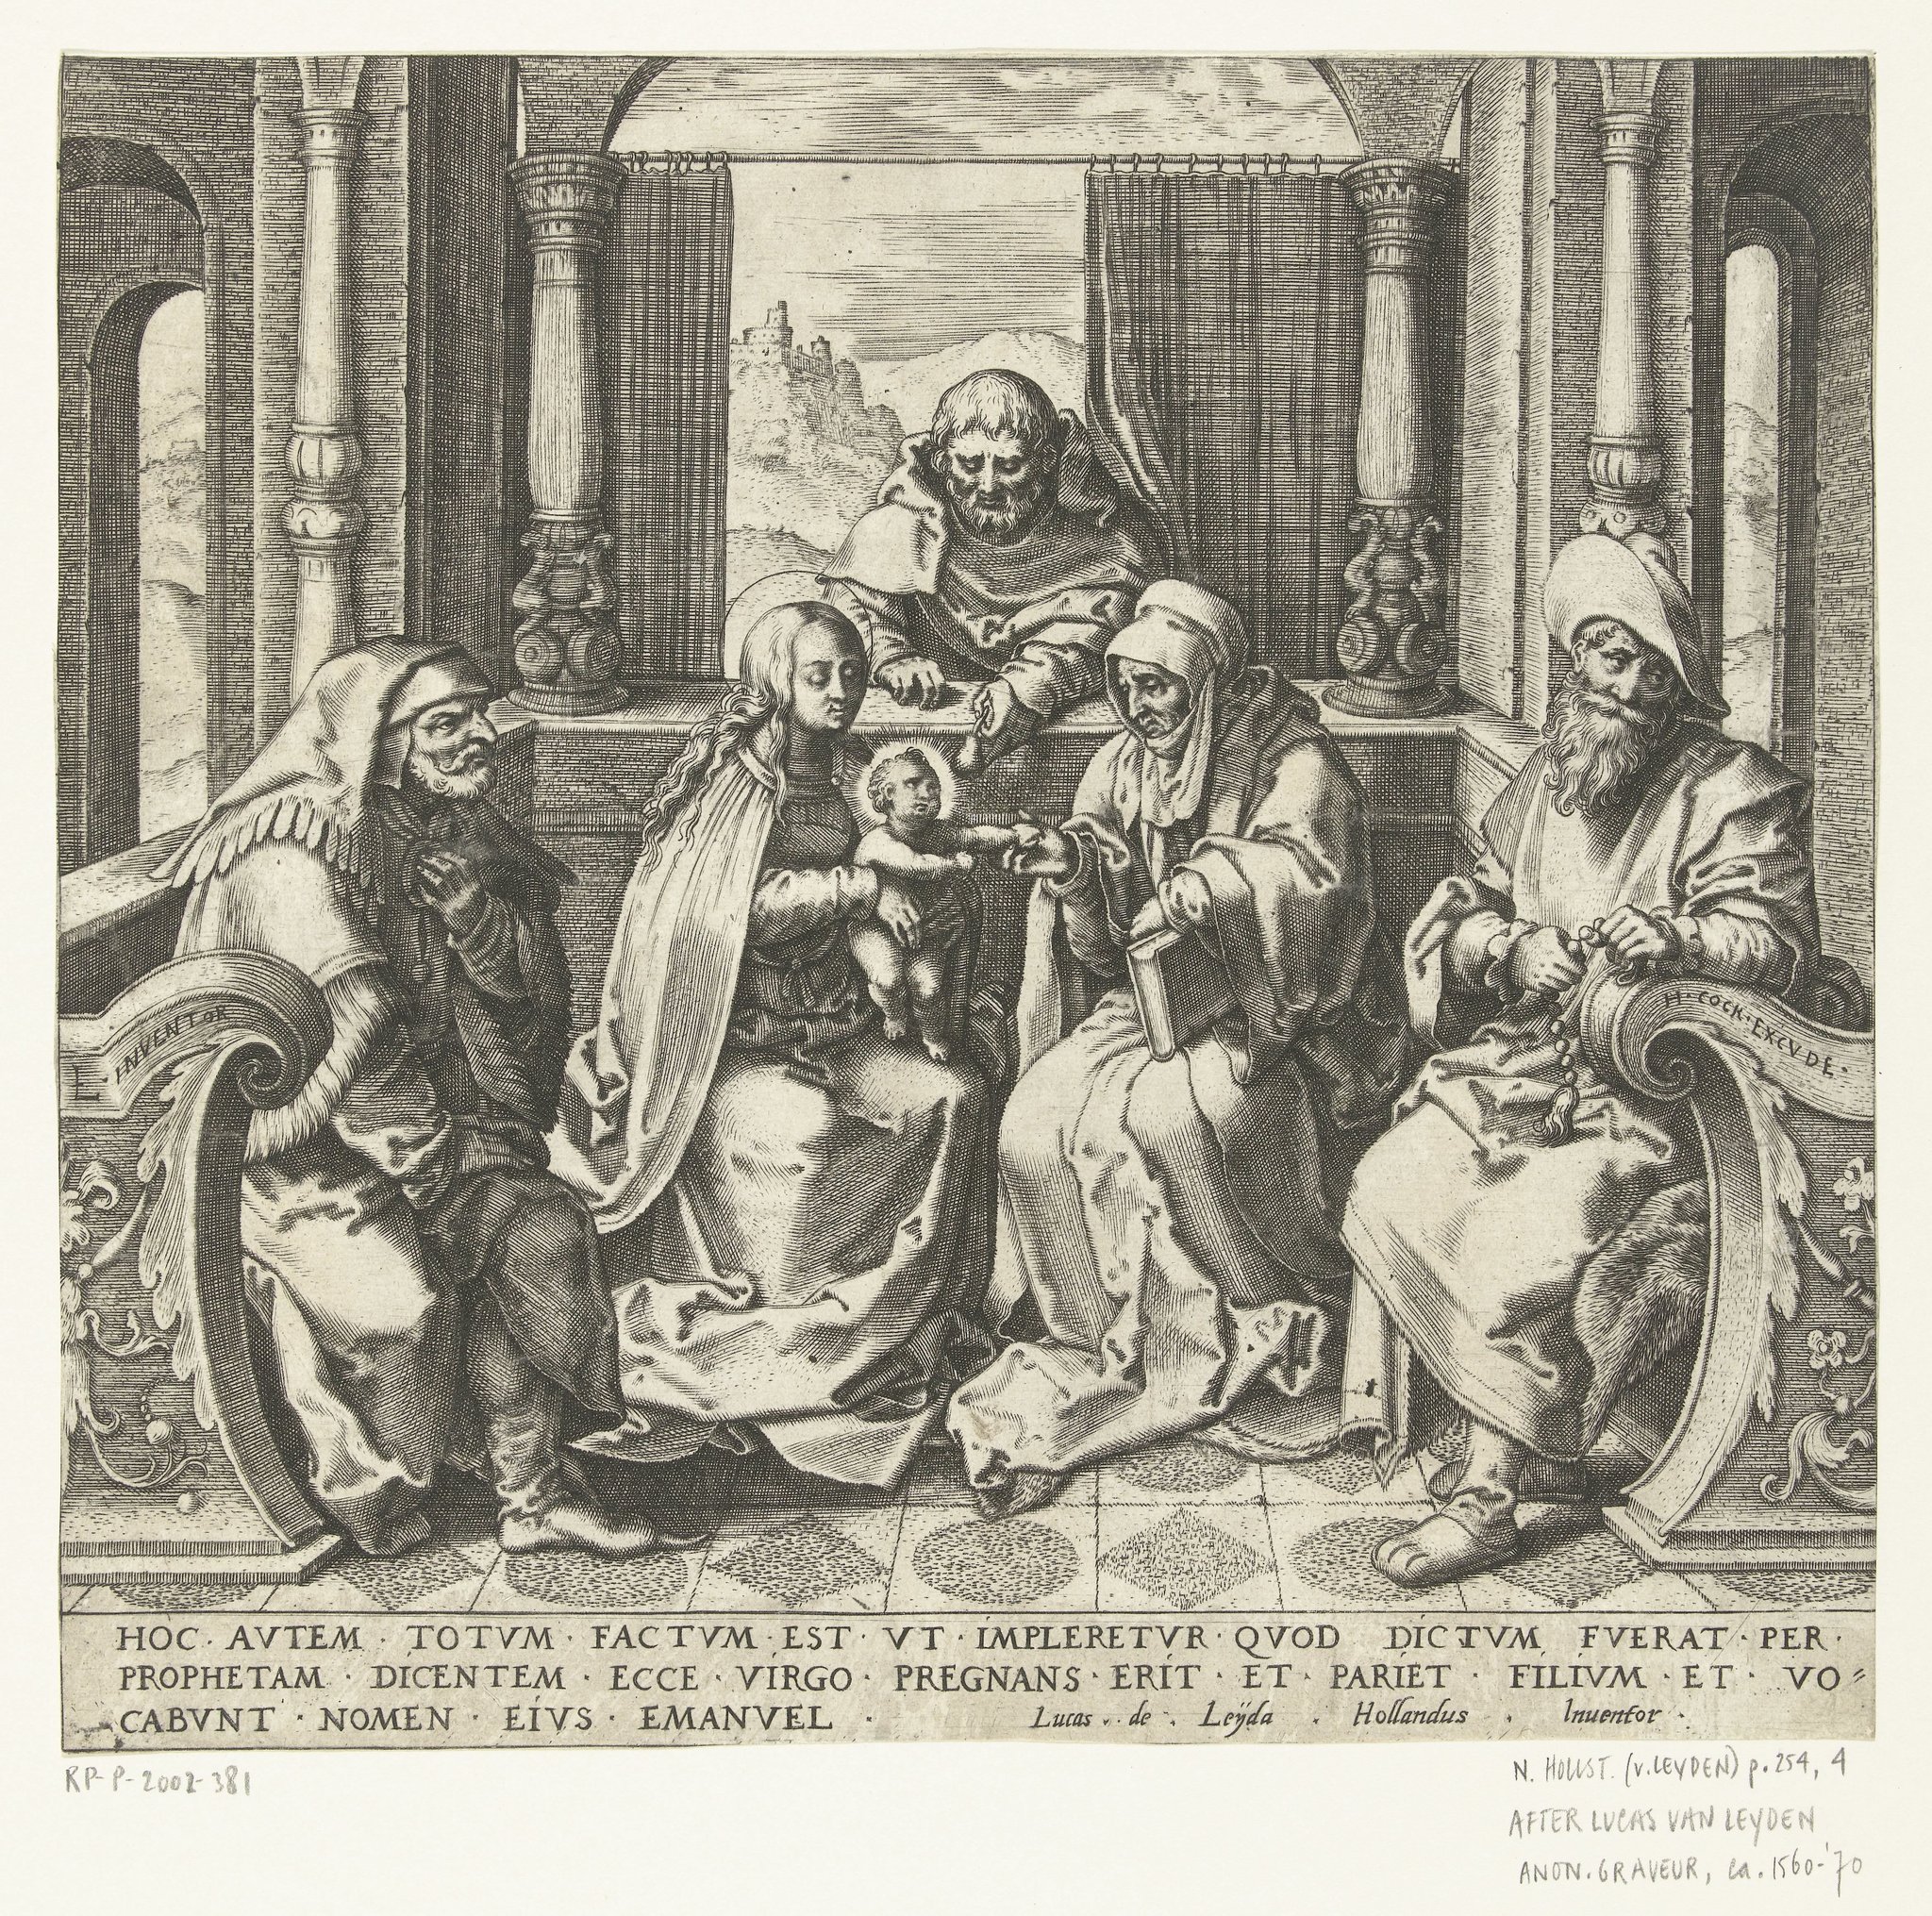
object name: print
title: Anna-te-Drieën met Jozef en twee mannelijke heiligen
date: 1560-1570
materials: paper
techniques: engraving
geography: netherlands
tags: 'anna selbdritt', i.e. anna, mary and christ-child close together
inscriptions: collector's mark: Lugt 2228a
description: Anna-te-Drieën met Jozef en twee mannelijke heiligen. Maria met Christuskind op schoot, naast haar de H. Anna. Jozef staat achter hen, leunend over een balustrade. Links en rechts van de heilige familie een zittende mannelijke figuur. Drie regels tekst onder afbeelding in het Latijn.